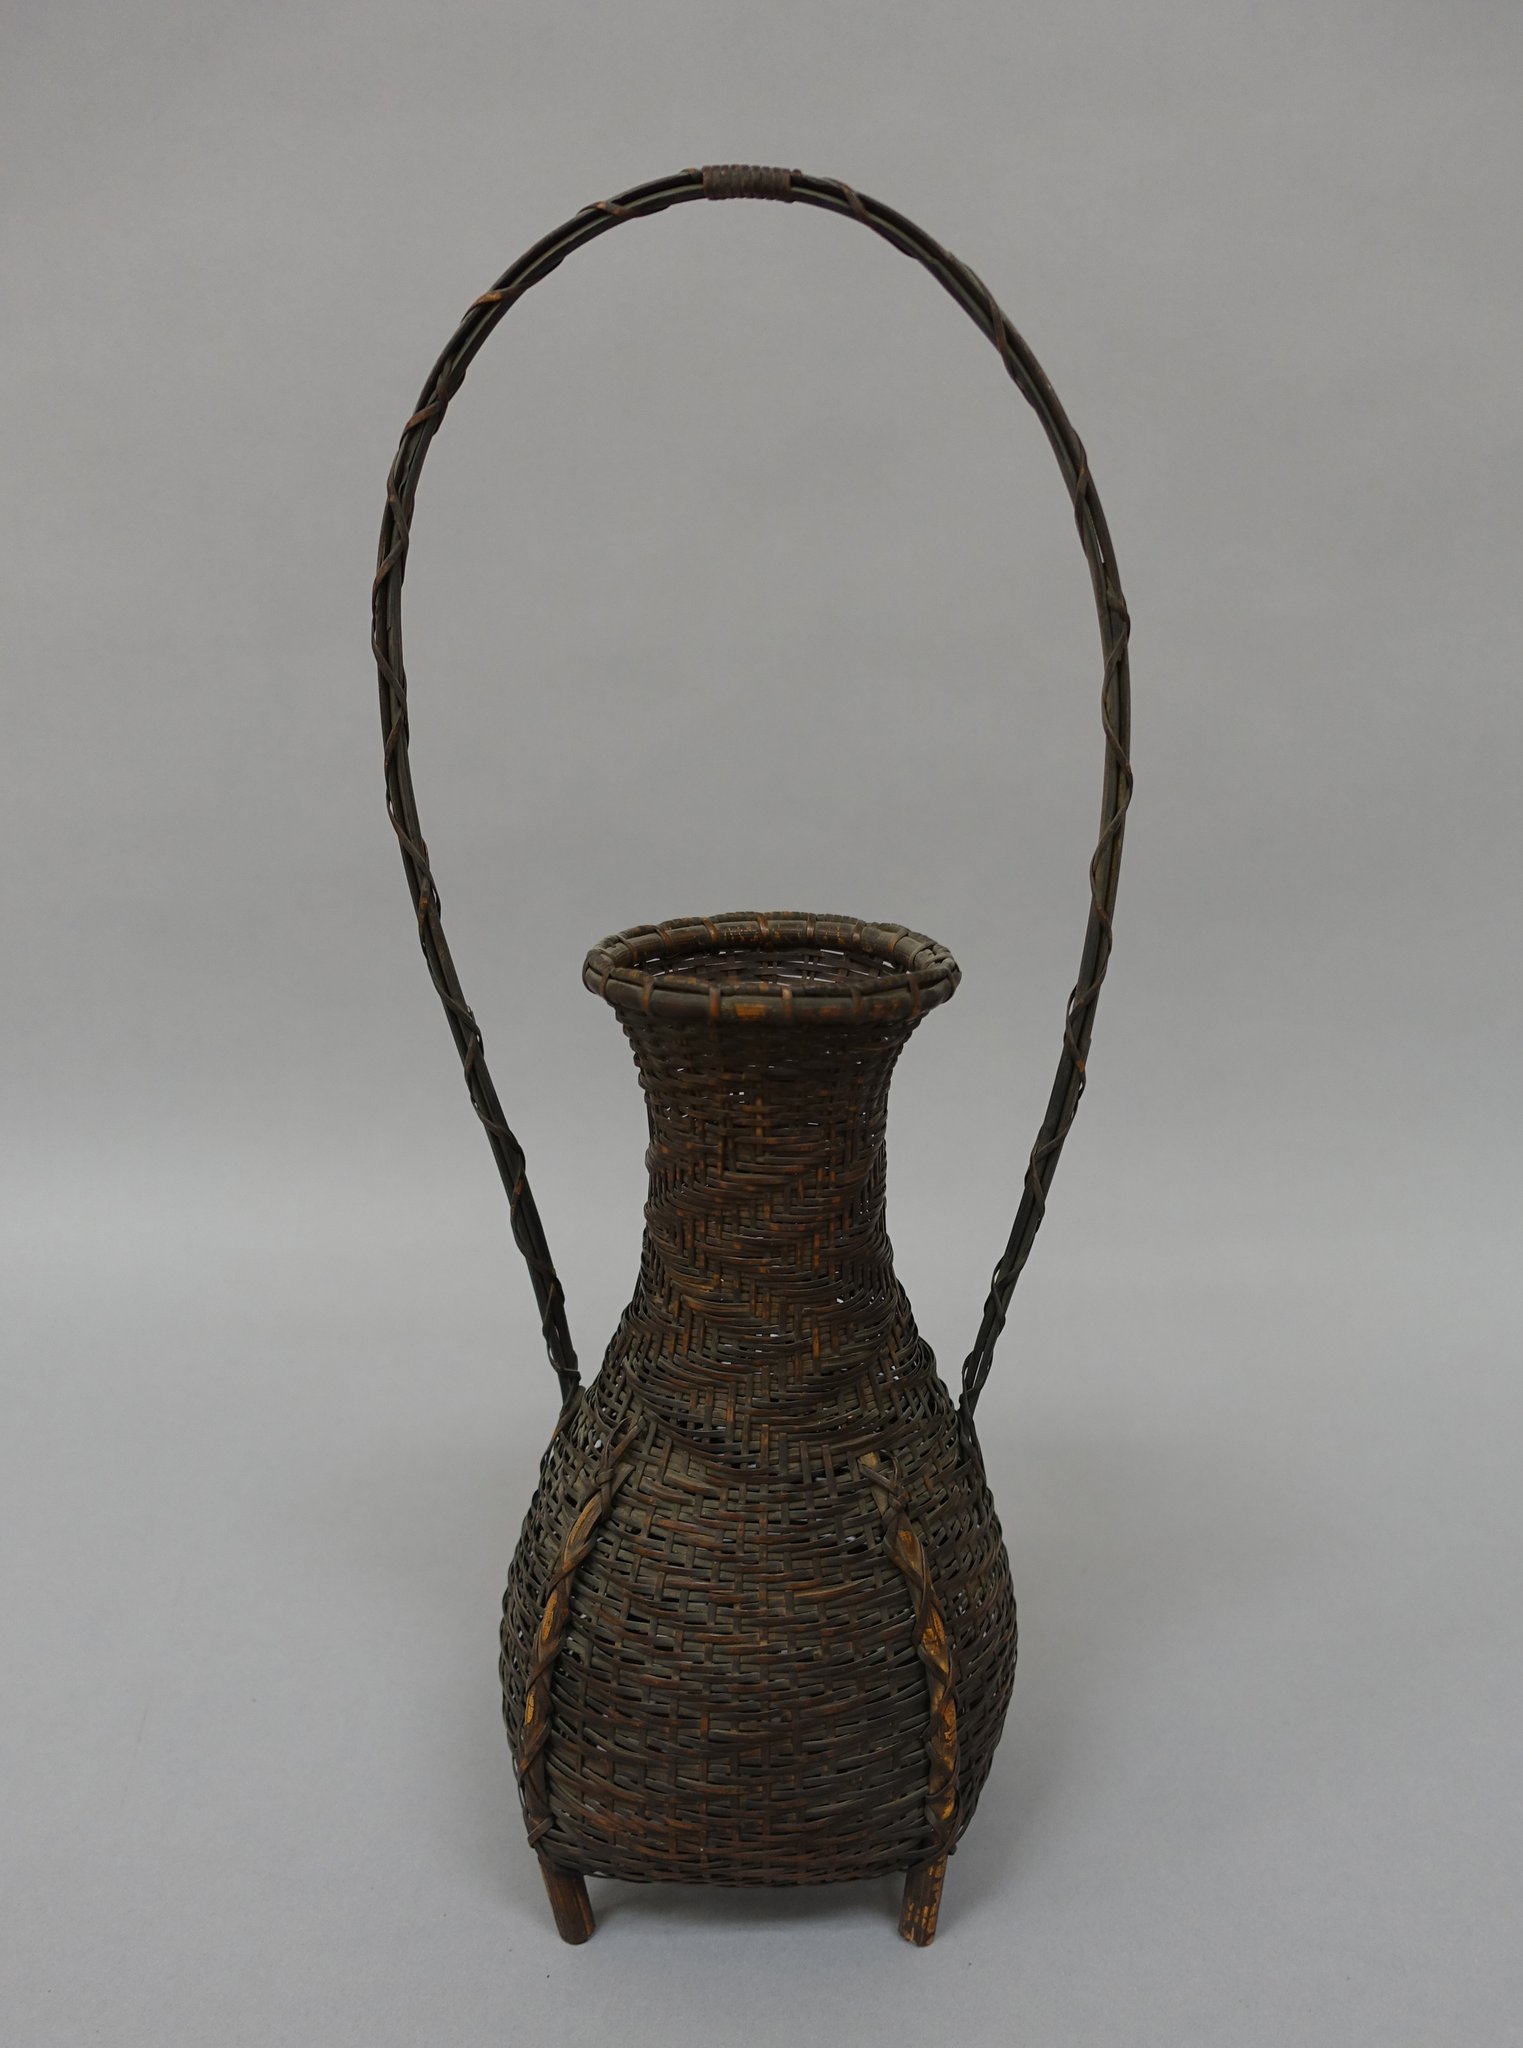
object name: basket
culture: japanese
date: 1801-1900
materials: bamboo